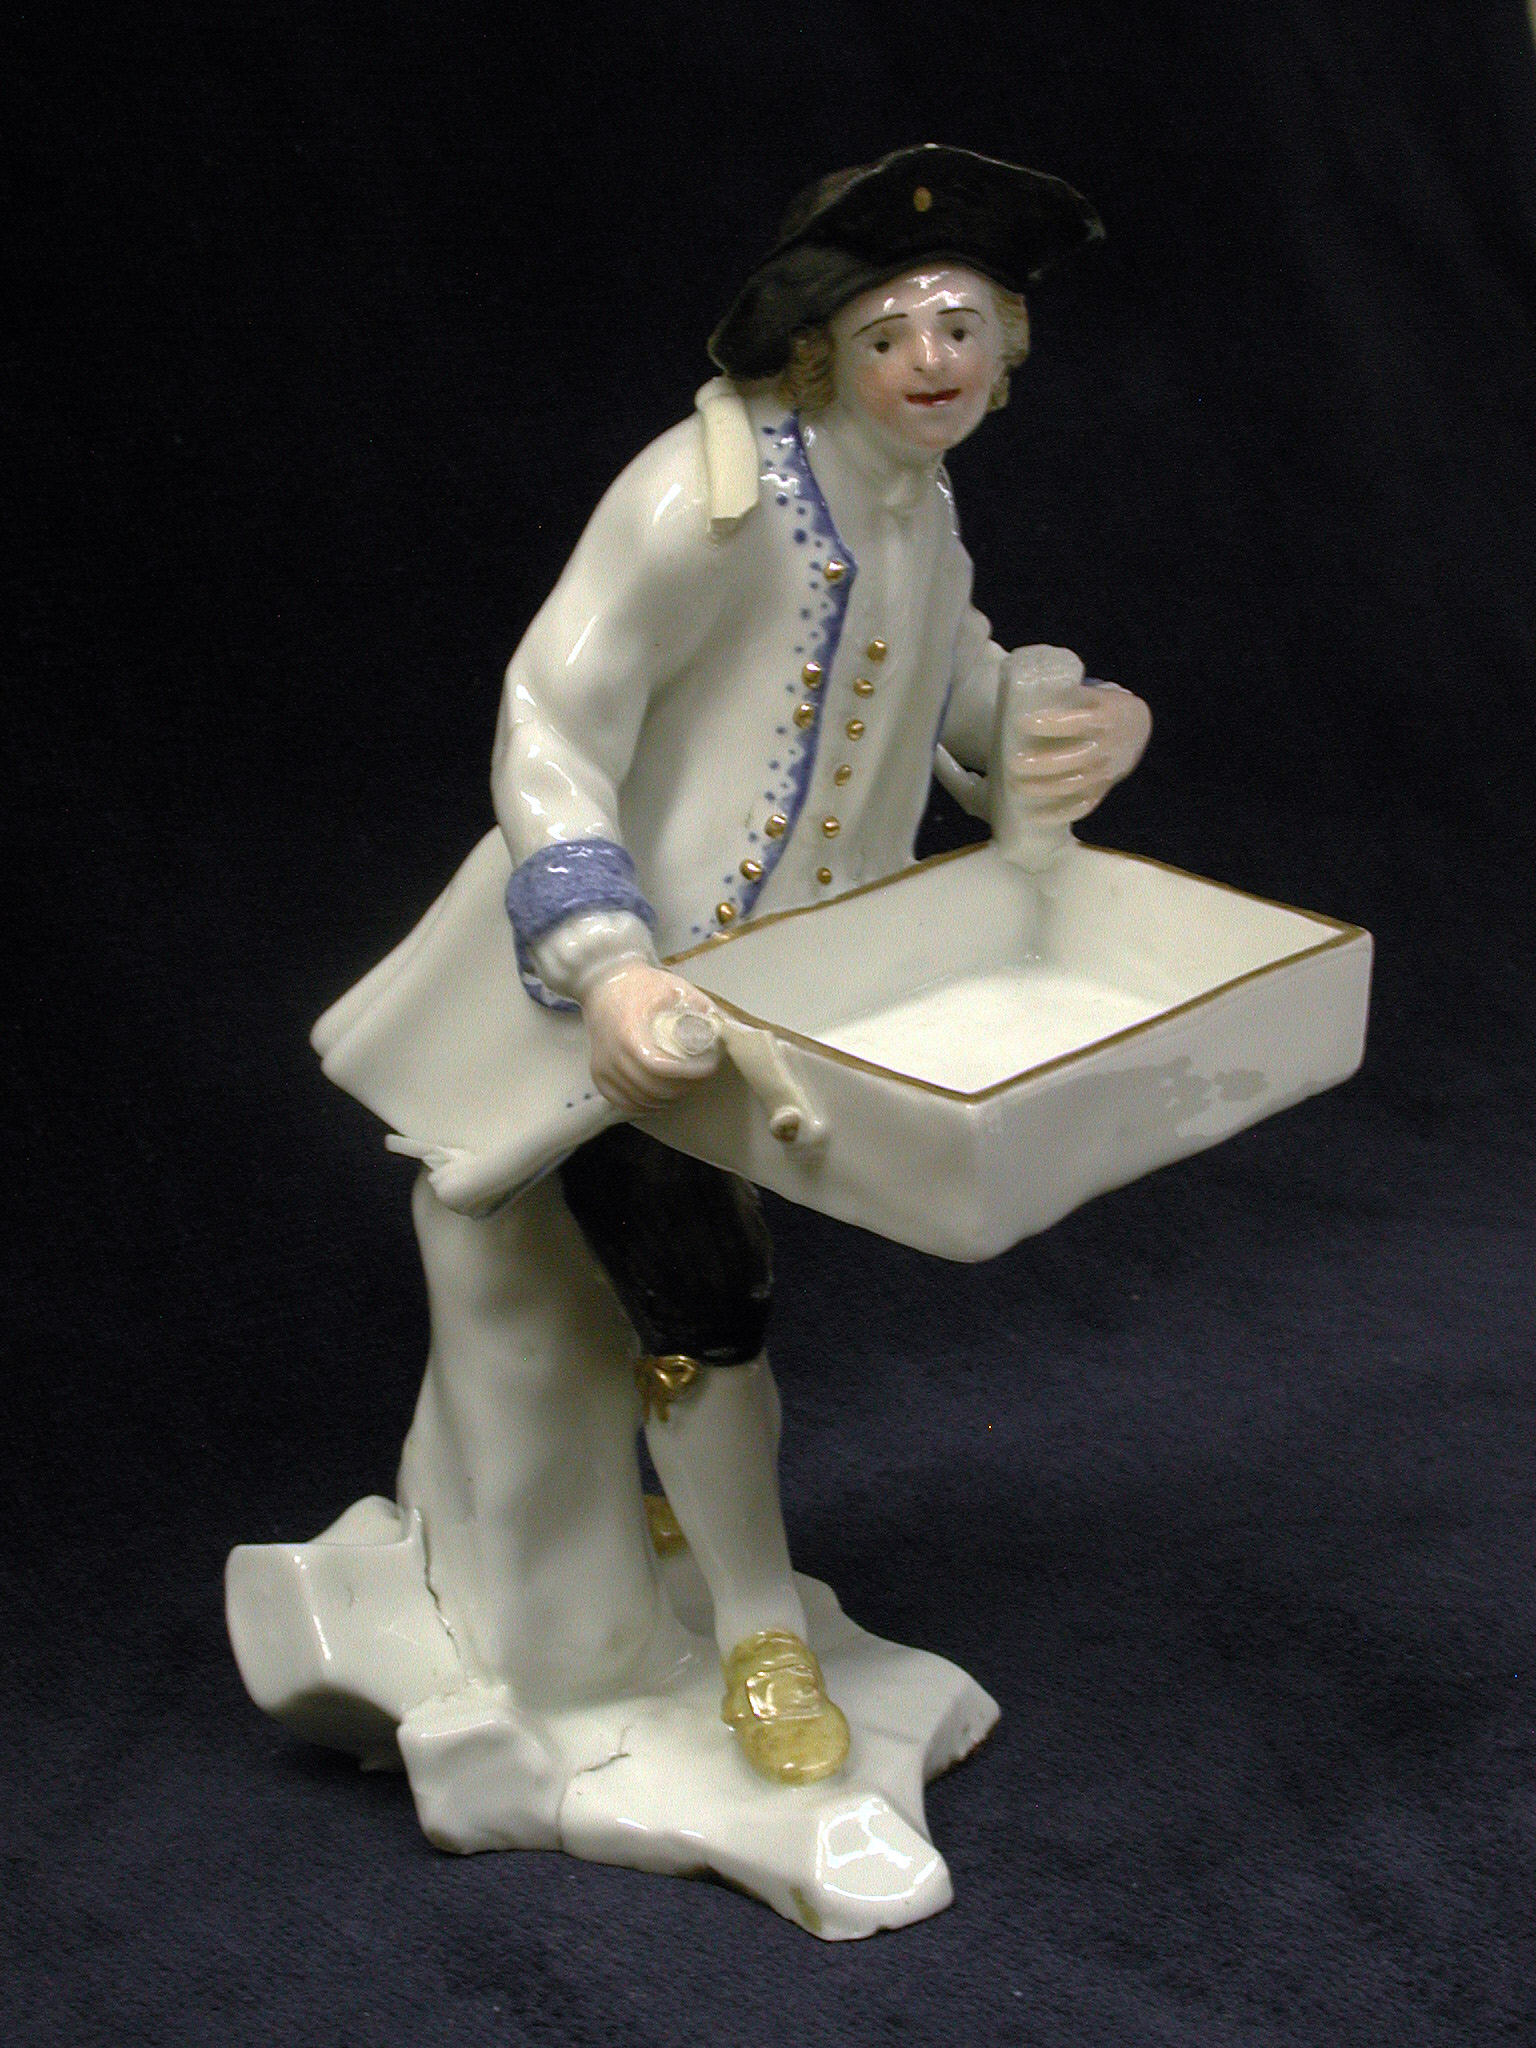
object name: figure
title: Peddler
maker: capodimonte porcelain manufactory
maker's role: manufactory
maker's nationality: italian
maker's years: 1740-1759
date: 1750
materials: soft paste porcelain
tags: men